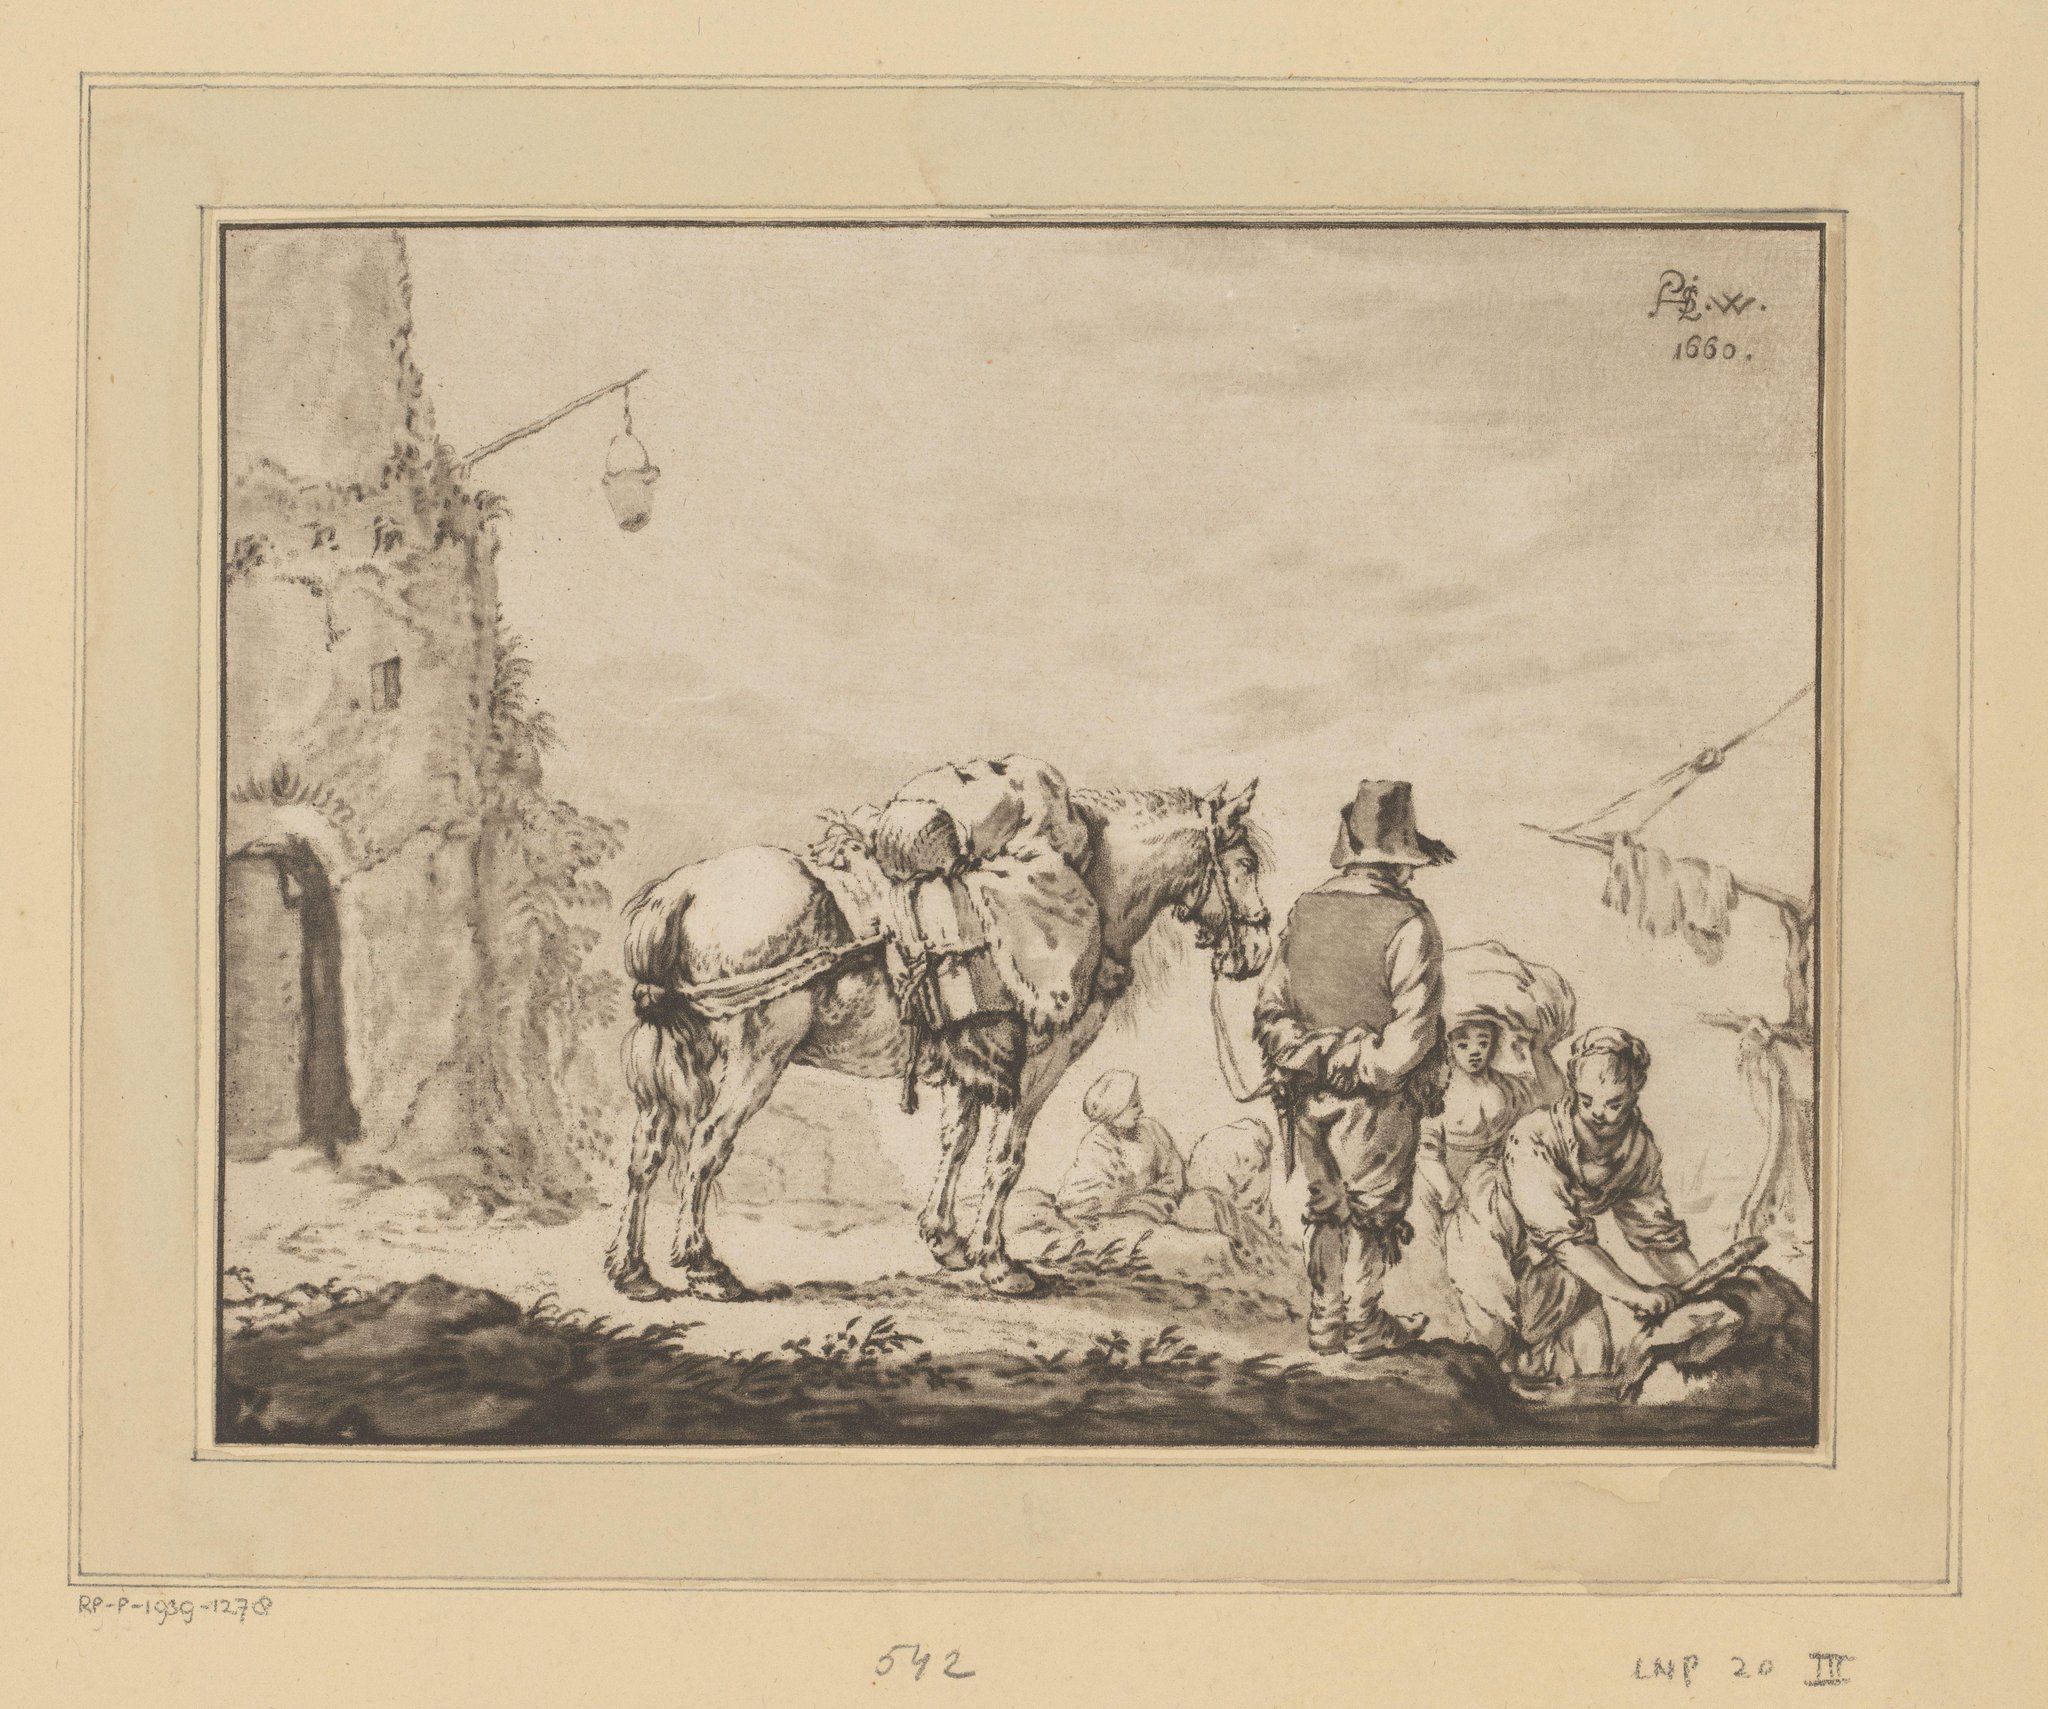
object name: print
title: Man met paard bij wasvrouw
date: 1772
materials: paper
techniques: printmaking, etching, roulette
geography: amsterdam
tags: laundering, horse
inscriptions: collector's mark: Lugt 2725, collector's mark: ‘RIJKS / MUSM’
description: Een man, houdt de teugels van zijn paard vast, terwijl hij bij een vrouw staat die de was doet. Zij staat tot haar knieën in het water. De prent ligt los in een album, zie blad 20.